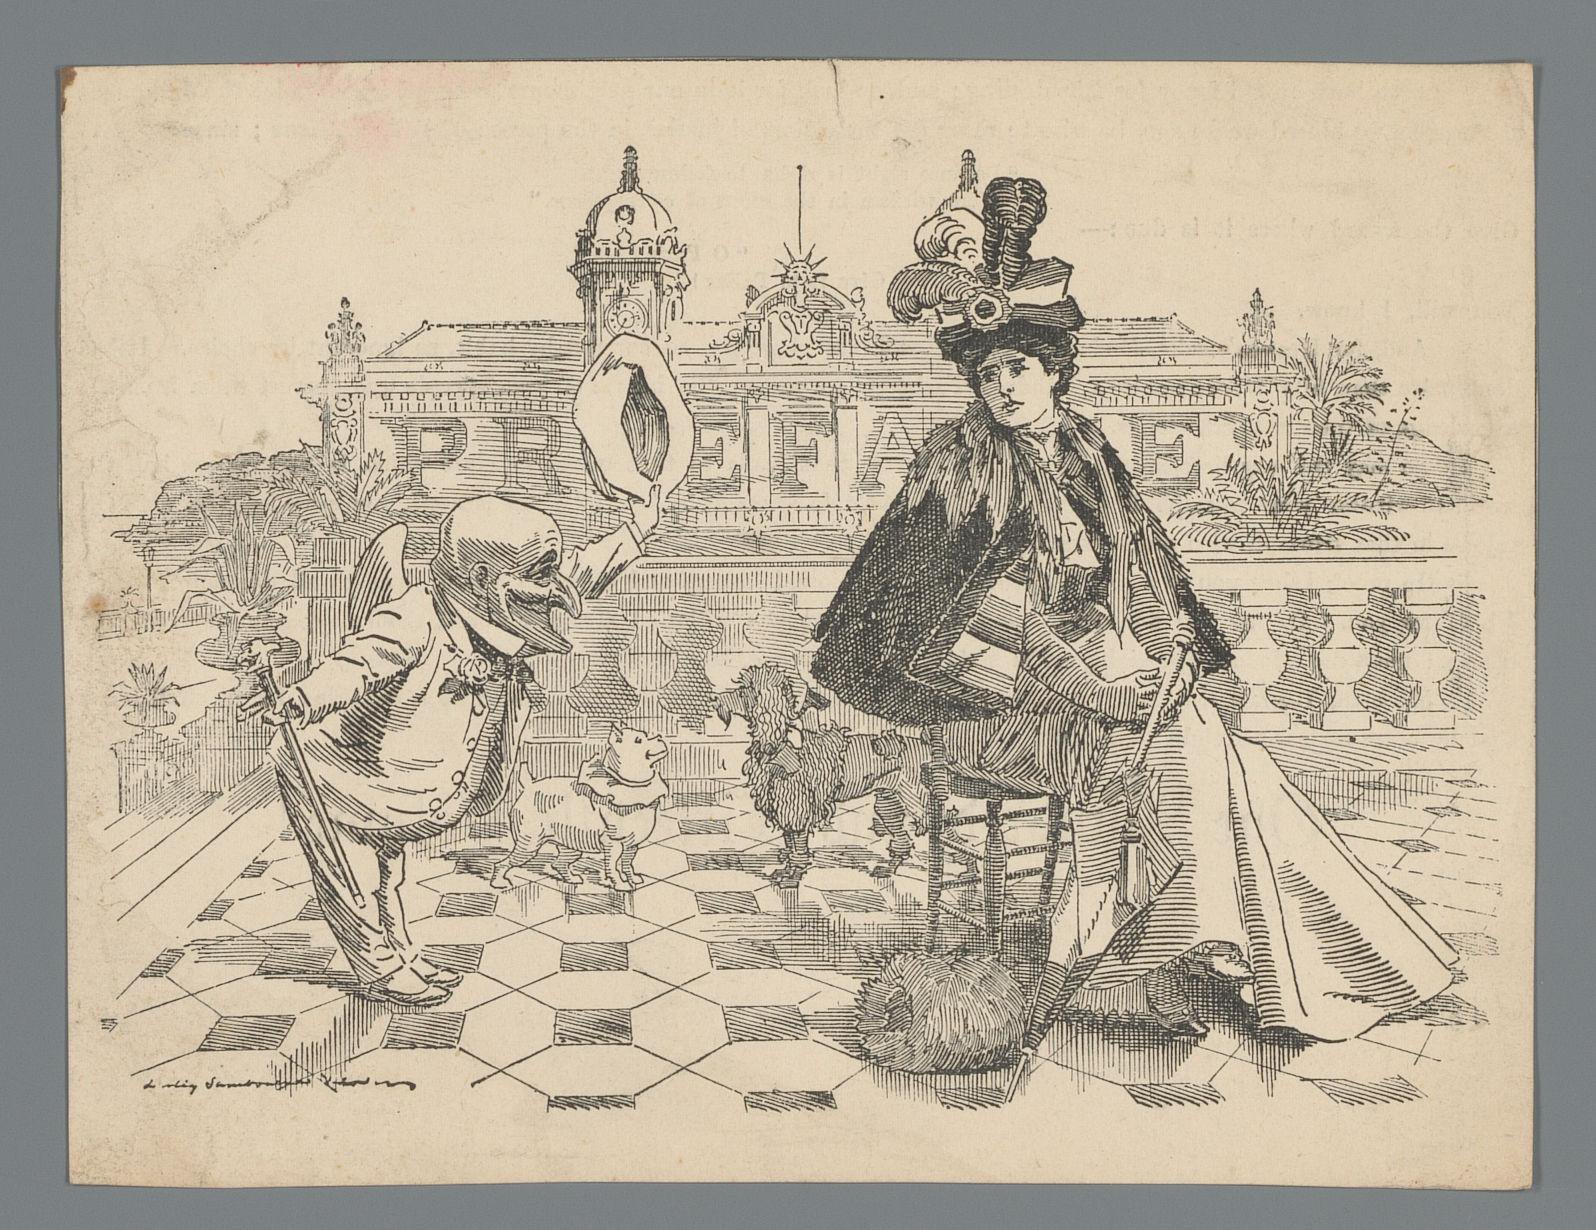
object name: cartoon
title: Vignet uit Punch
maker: edward linley sambourne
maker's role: draughtsman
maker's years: 1844-1910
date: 1898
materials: paper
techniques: line block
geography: england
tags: political caricatures and satires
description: Mr. Punch buigt en neemt zijn hoed af voor een zittende dame. Vignet uit het Engelse satirische tijdschrift Punch, Preface vol. 115, 1898.